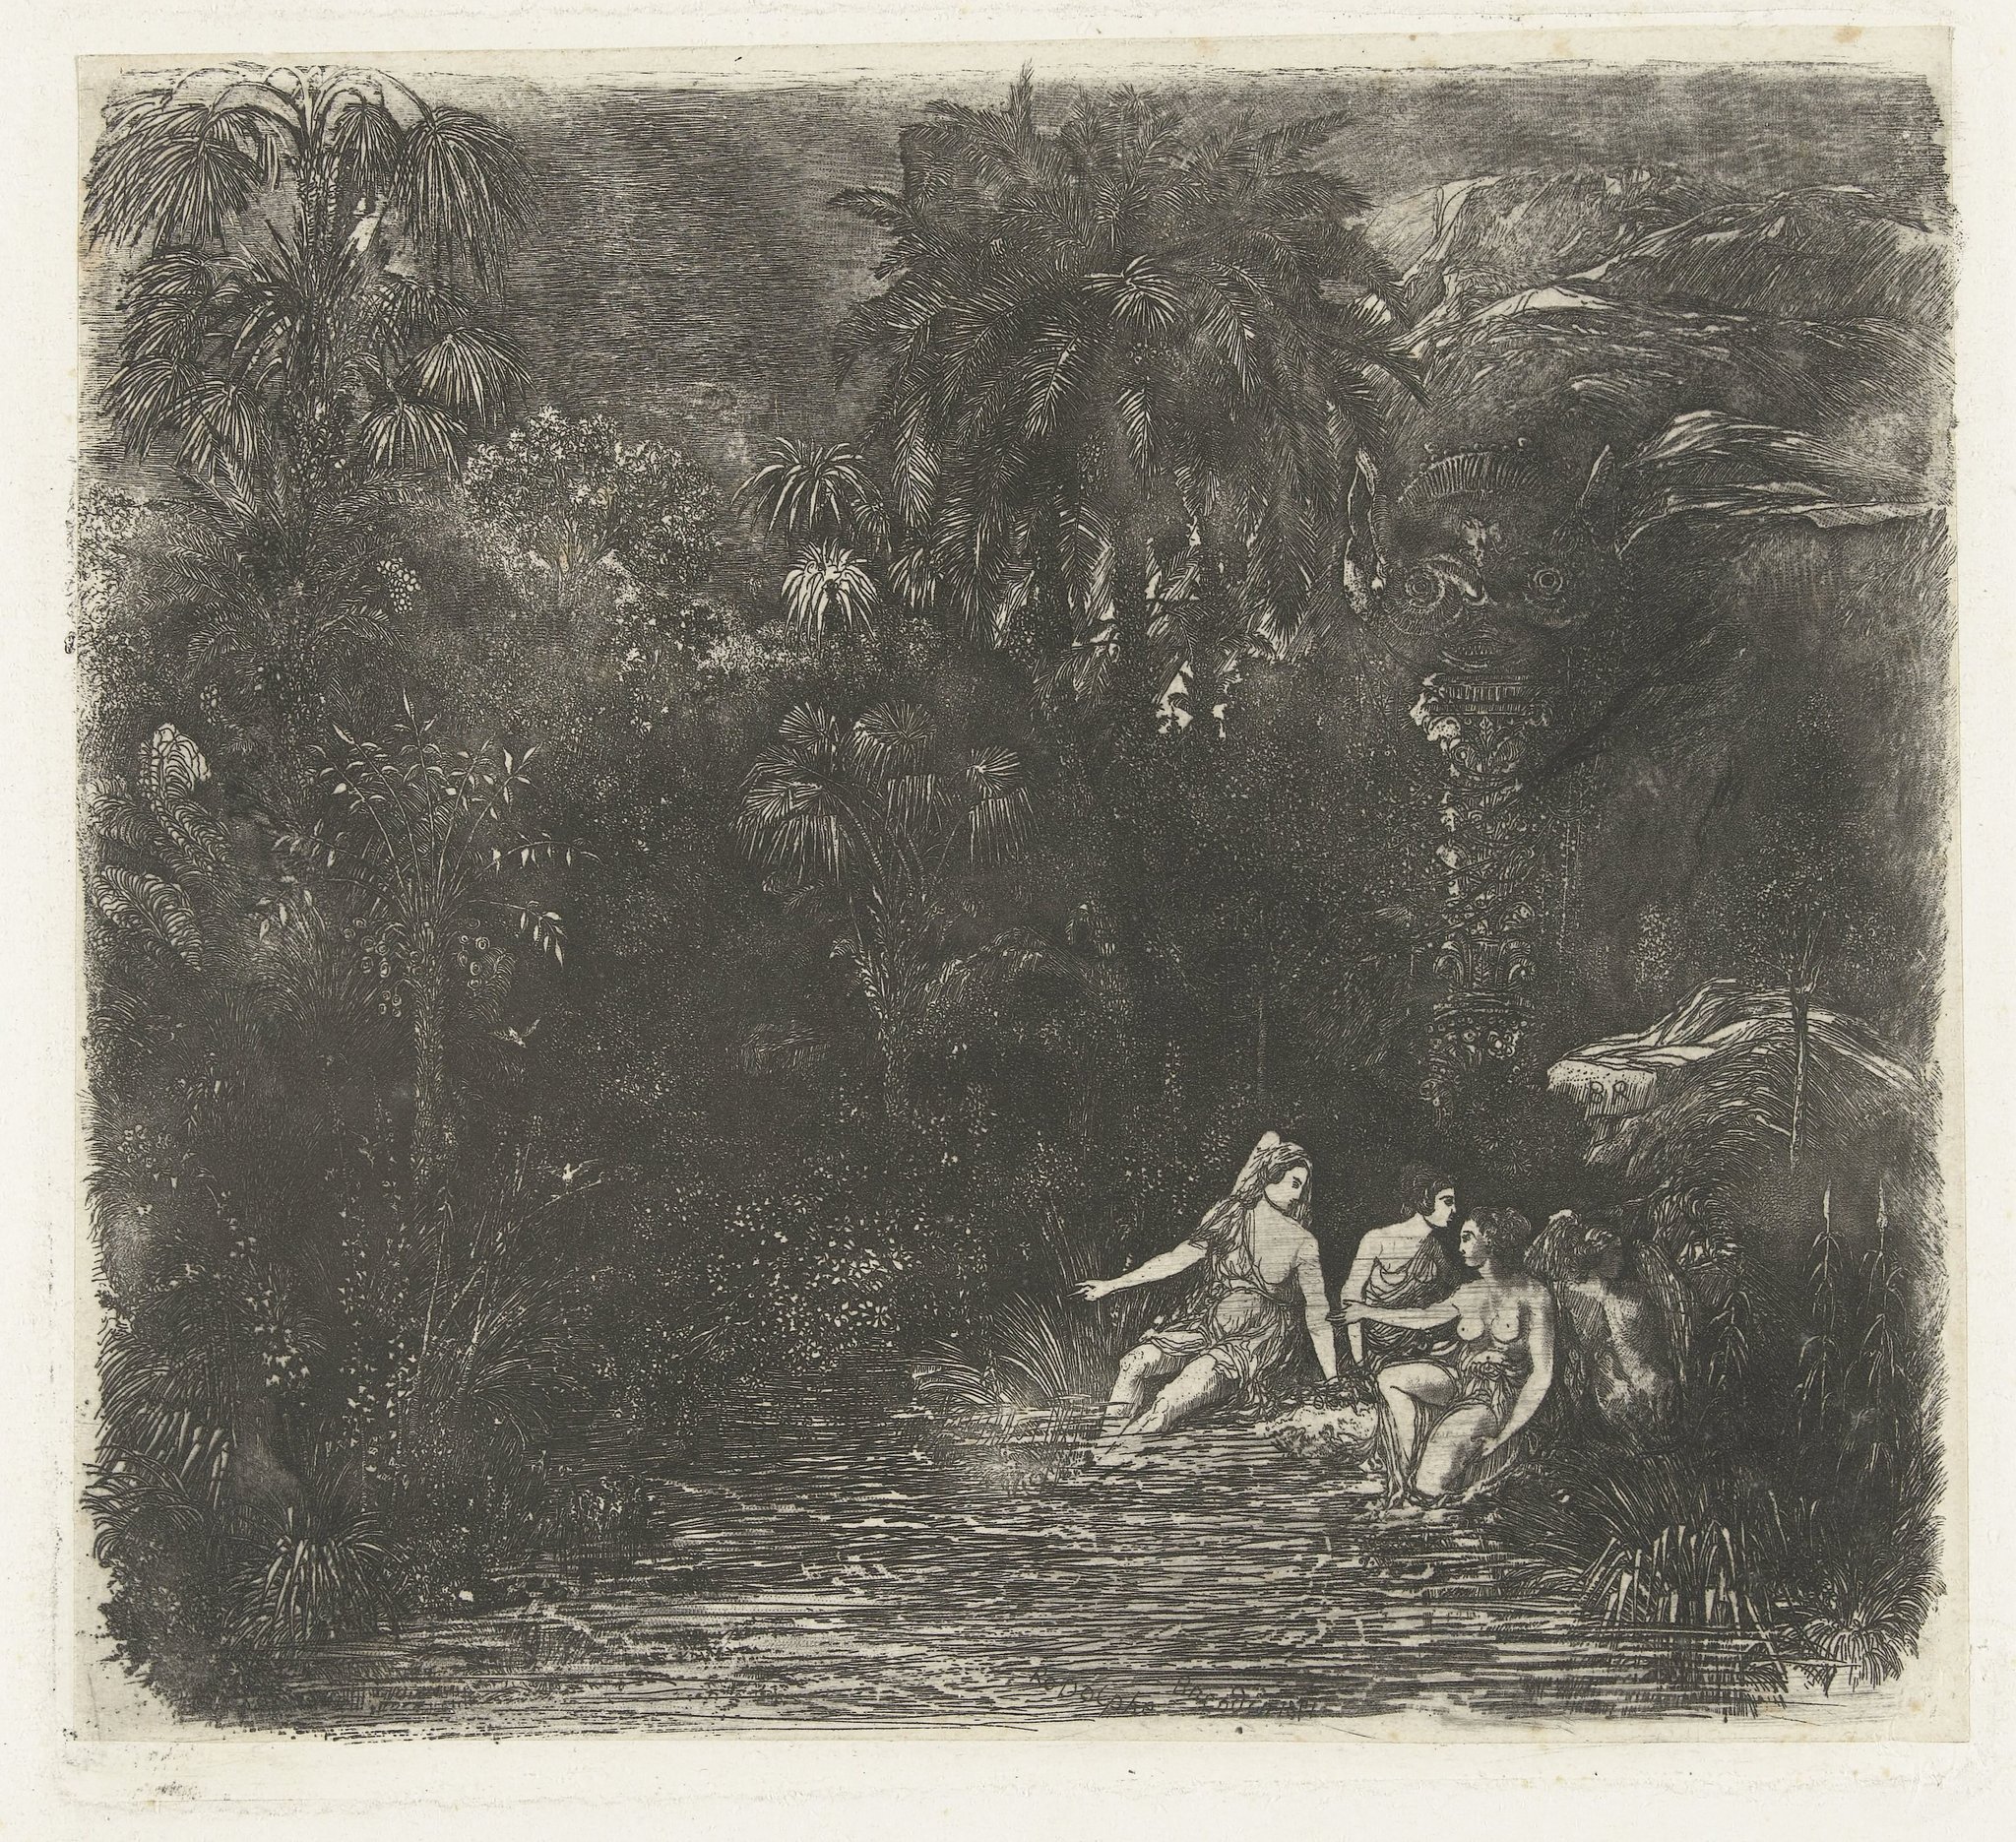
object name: print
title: Les baigneuses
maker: rodolphe bresdin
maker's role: draughtsman, print maker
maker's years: 1822-1885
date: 1871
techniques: printmaking, etching, roulette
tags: female sex; woman, washing and bathing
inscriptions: collector's mark: Lugt 1989a, collector's mark: Lugt 2194, collector's mark: Lugt 421, collector's mark: Lugt 2760, collector's mark: Lugt 2228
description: Landschap met een groep van vier badende vrouwen op de oever van een meer. Op de oever staan palmbomen en een gevaarlijk uitziend monument met een soort dierenkop op een zuil.